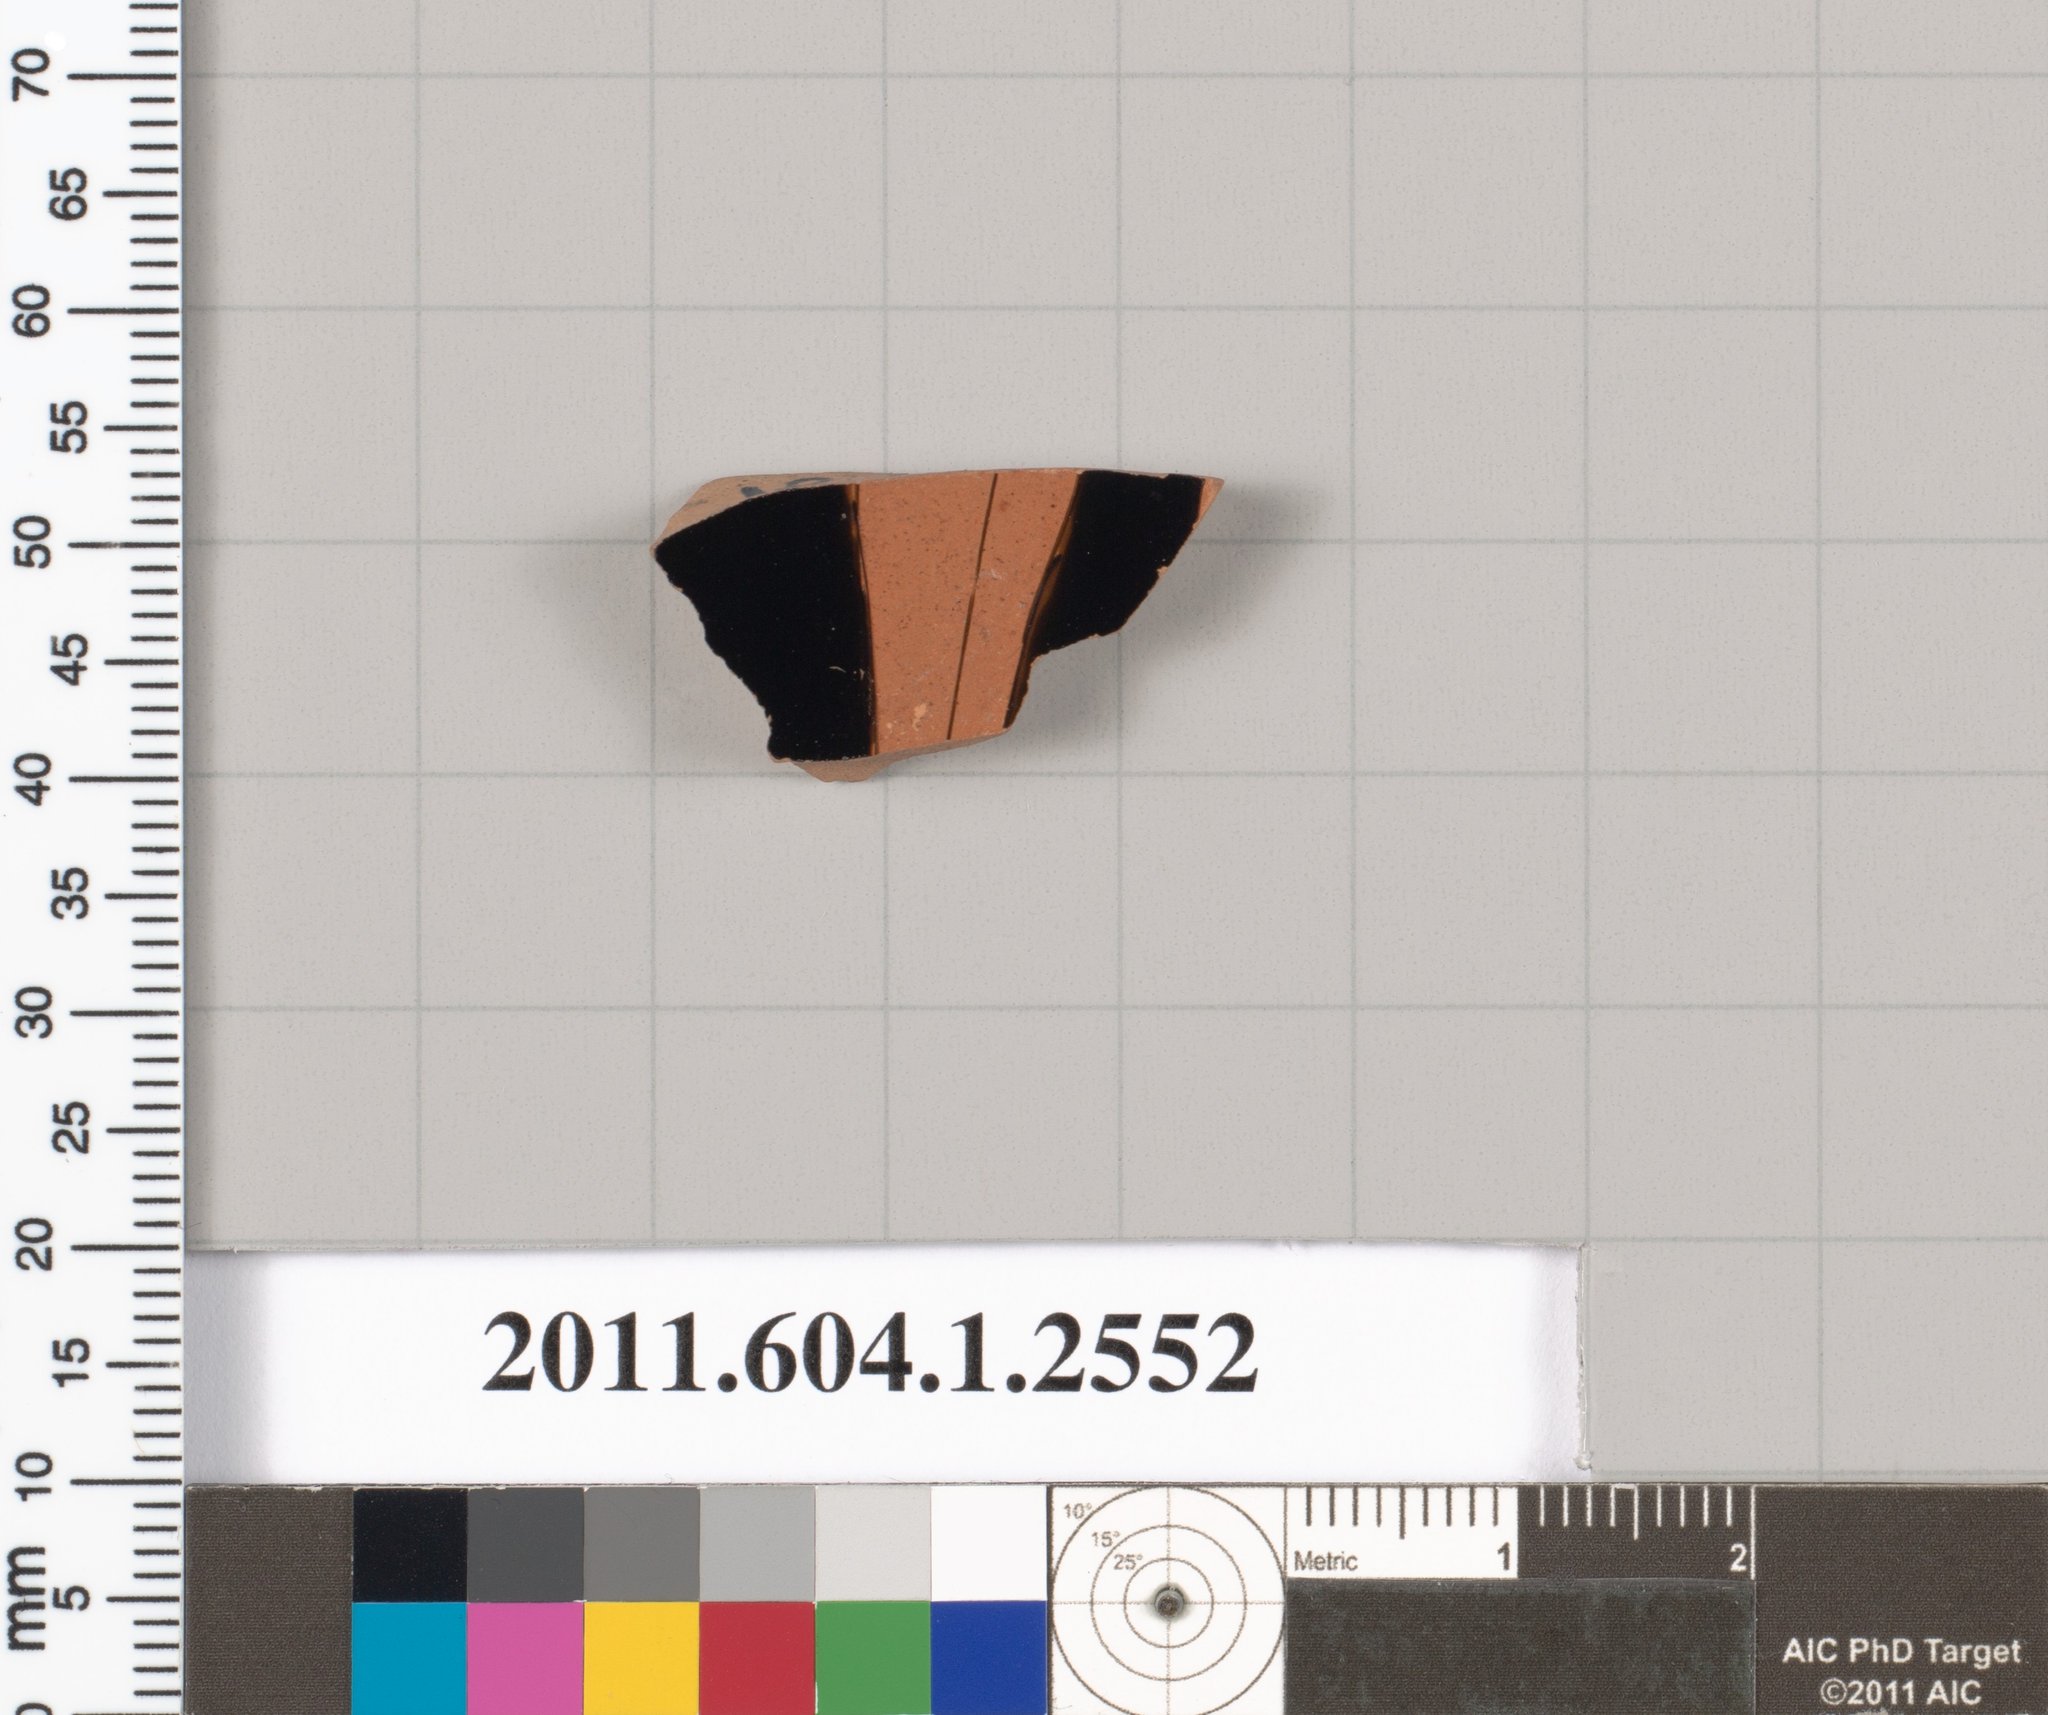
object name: kylix fragment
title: Terracotta fragment of a kylix (drinking cup)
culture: greek, attic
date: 475-451 BCE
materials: terracotta